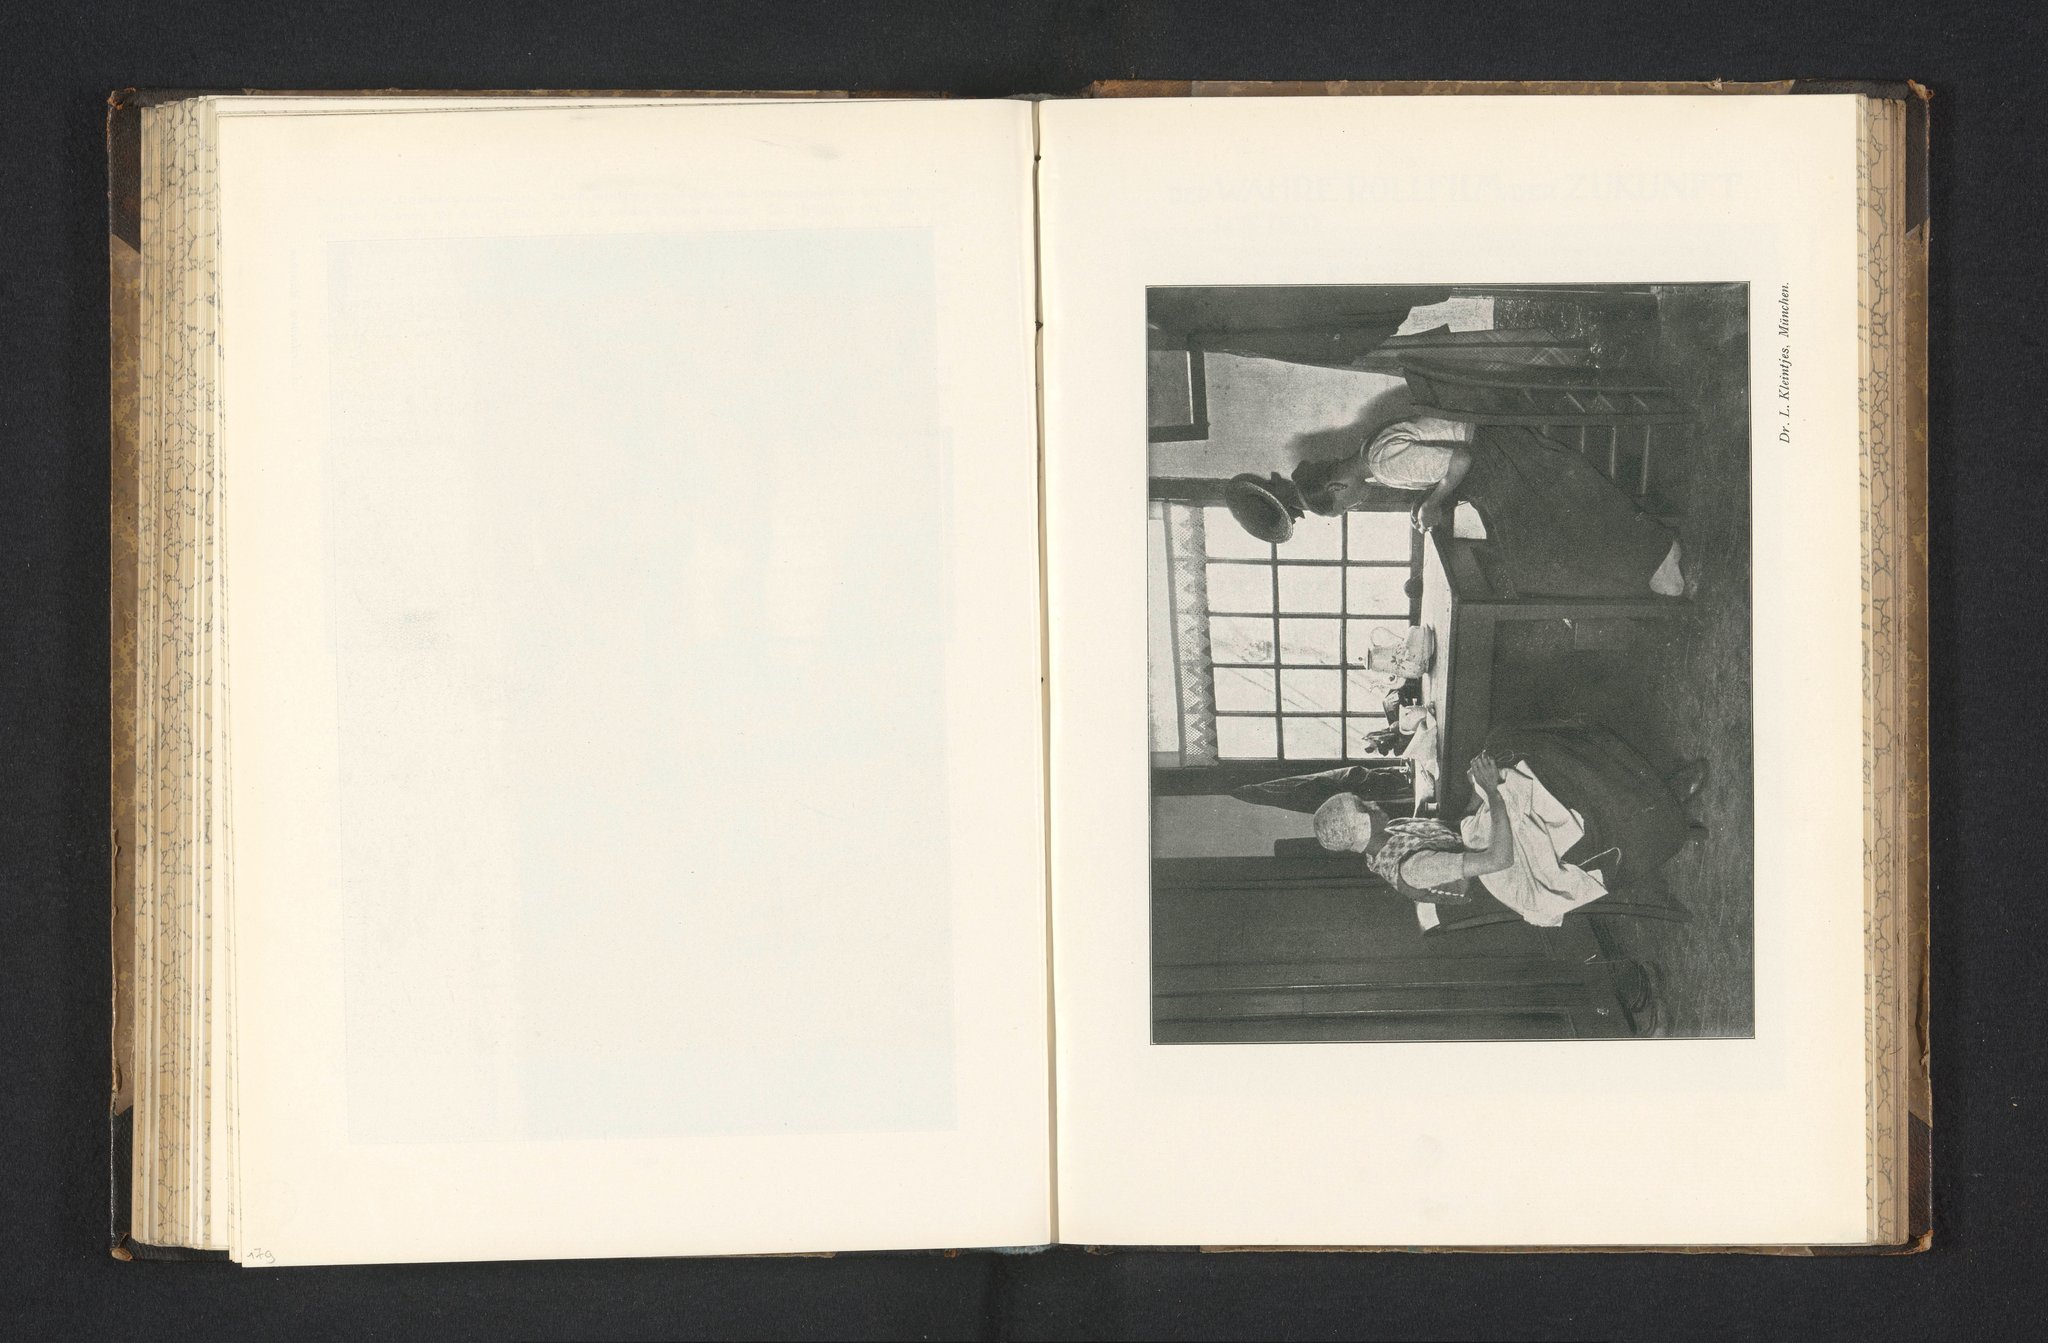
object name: photomechanical print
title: Twee vrouwen zitten aan een tafel te handwerken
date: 1898-1903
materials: paper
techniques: autotype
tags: mending, repairing ~ clothes, adult woman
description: Prent op tweede ongenummerde pagina na pagina 290.